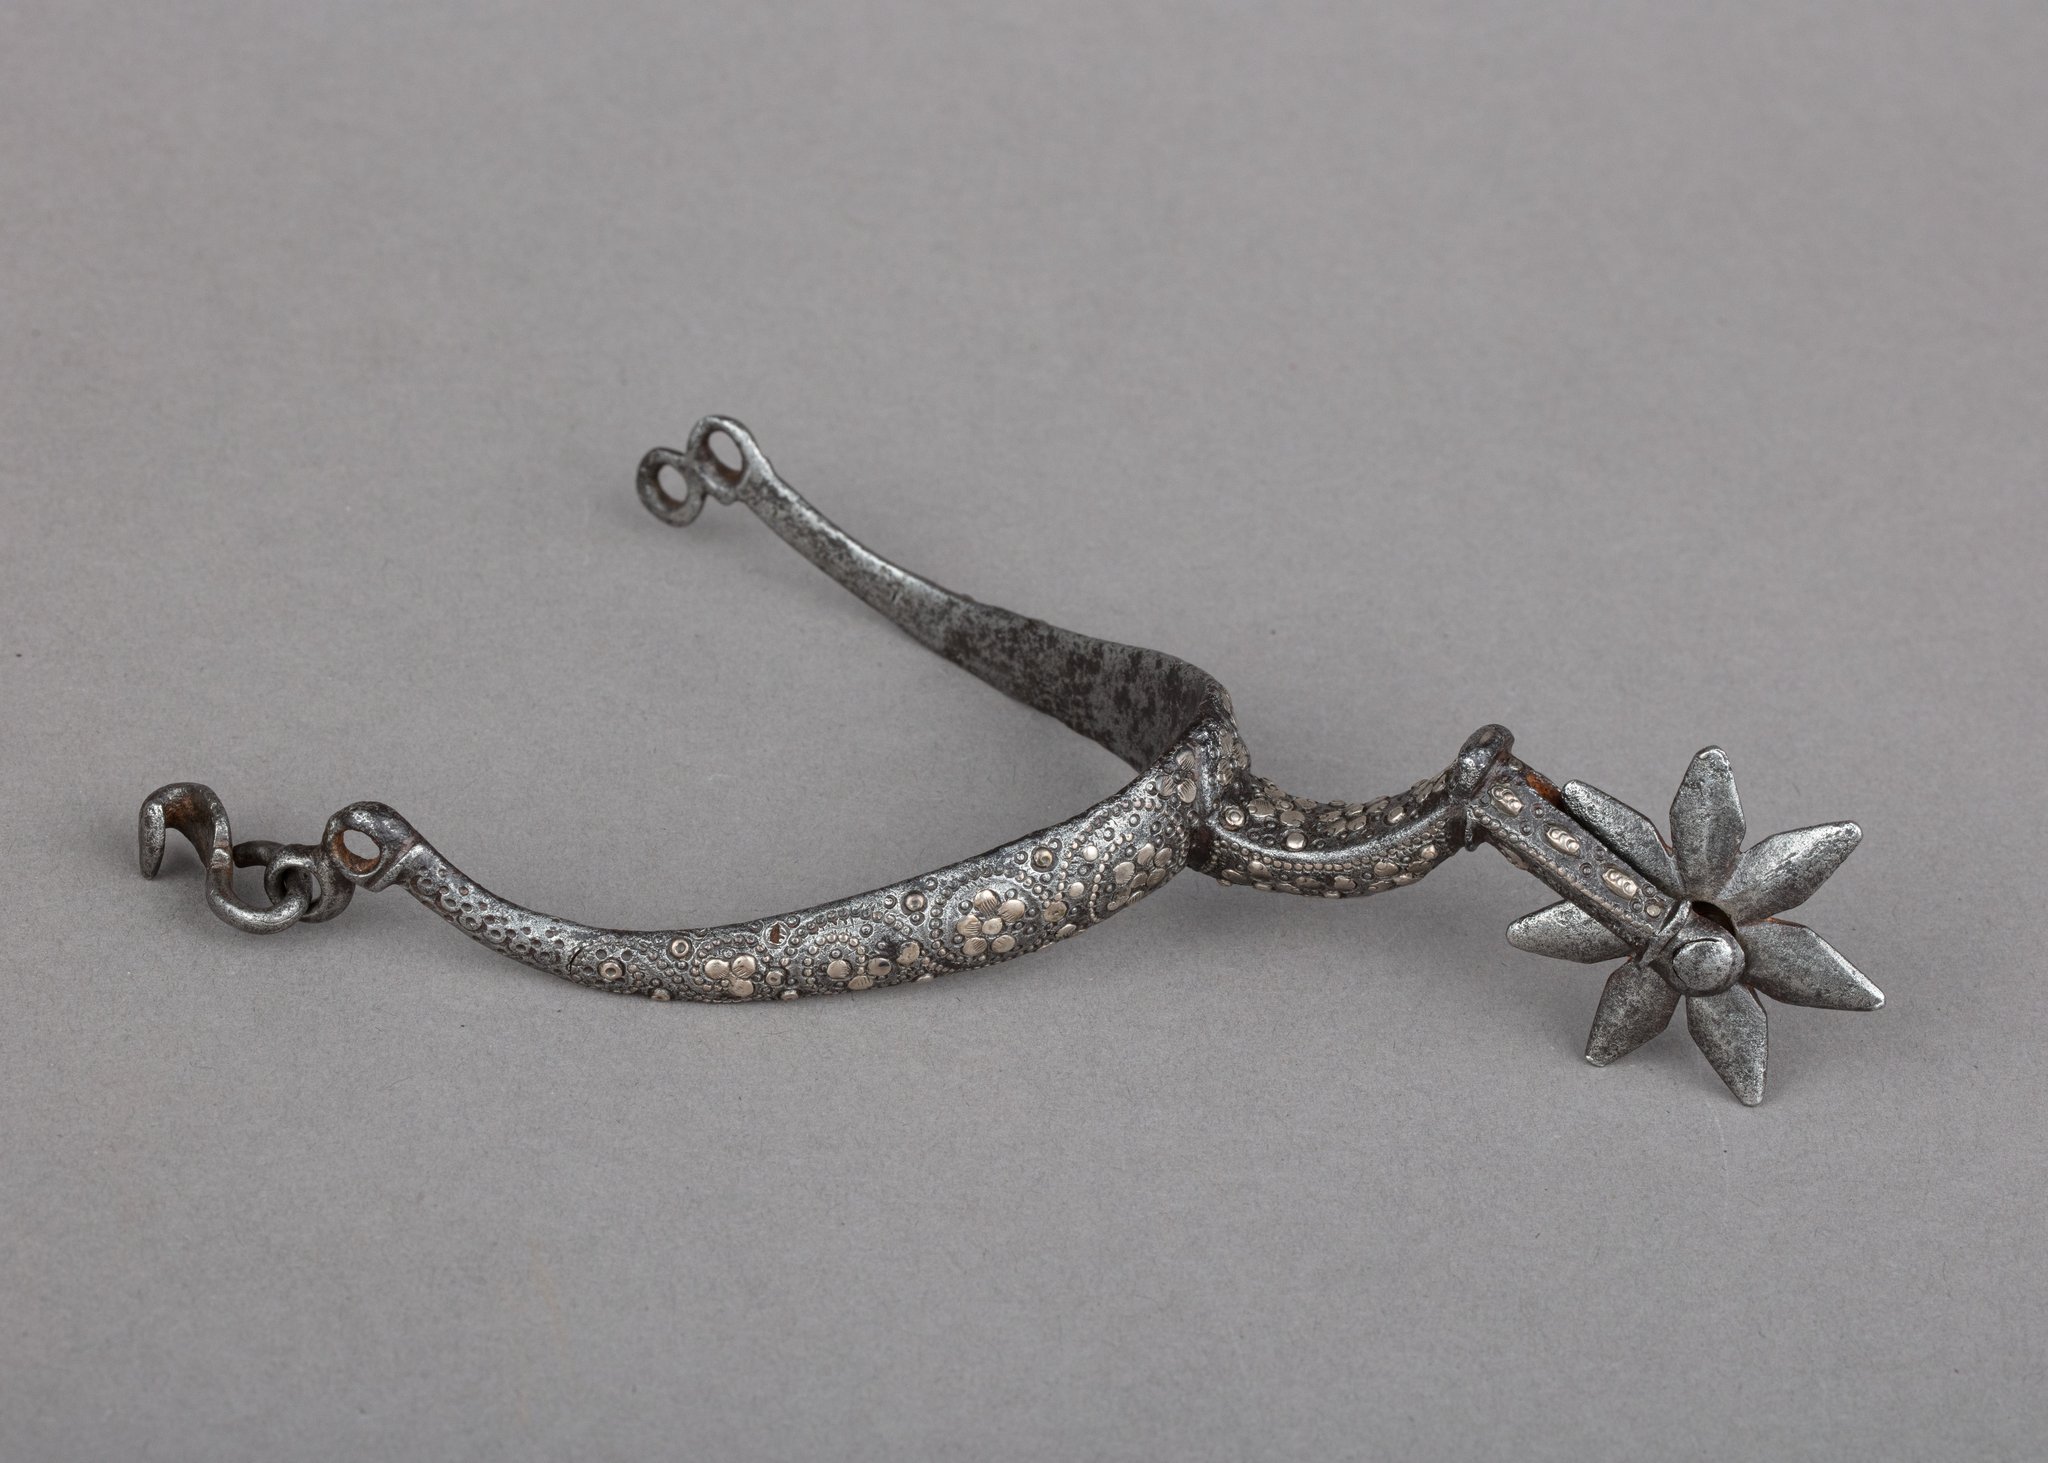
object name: spur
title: Rowel Spur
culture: british or german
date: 1601-1650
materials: metal alloy, silver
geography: germany